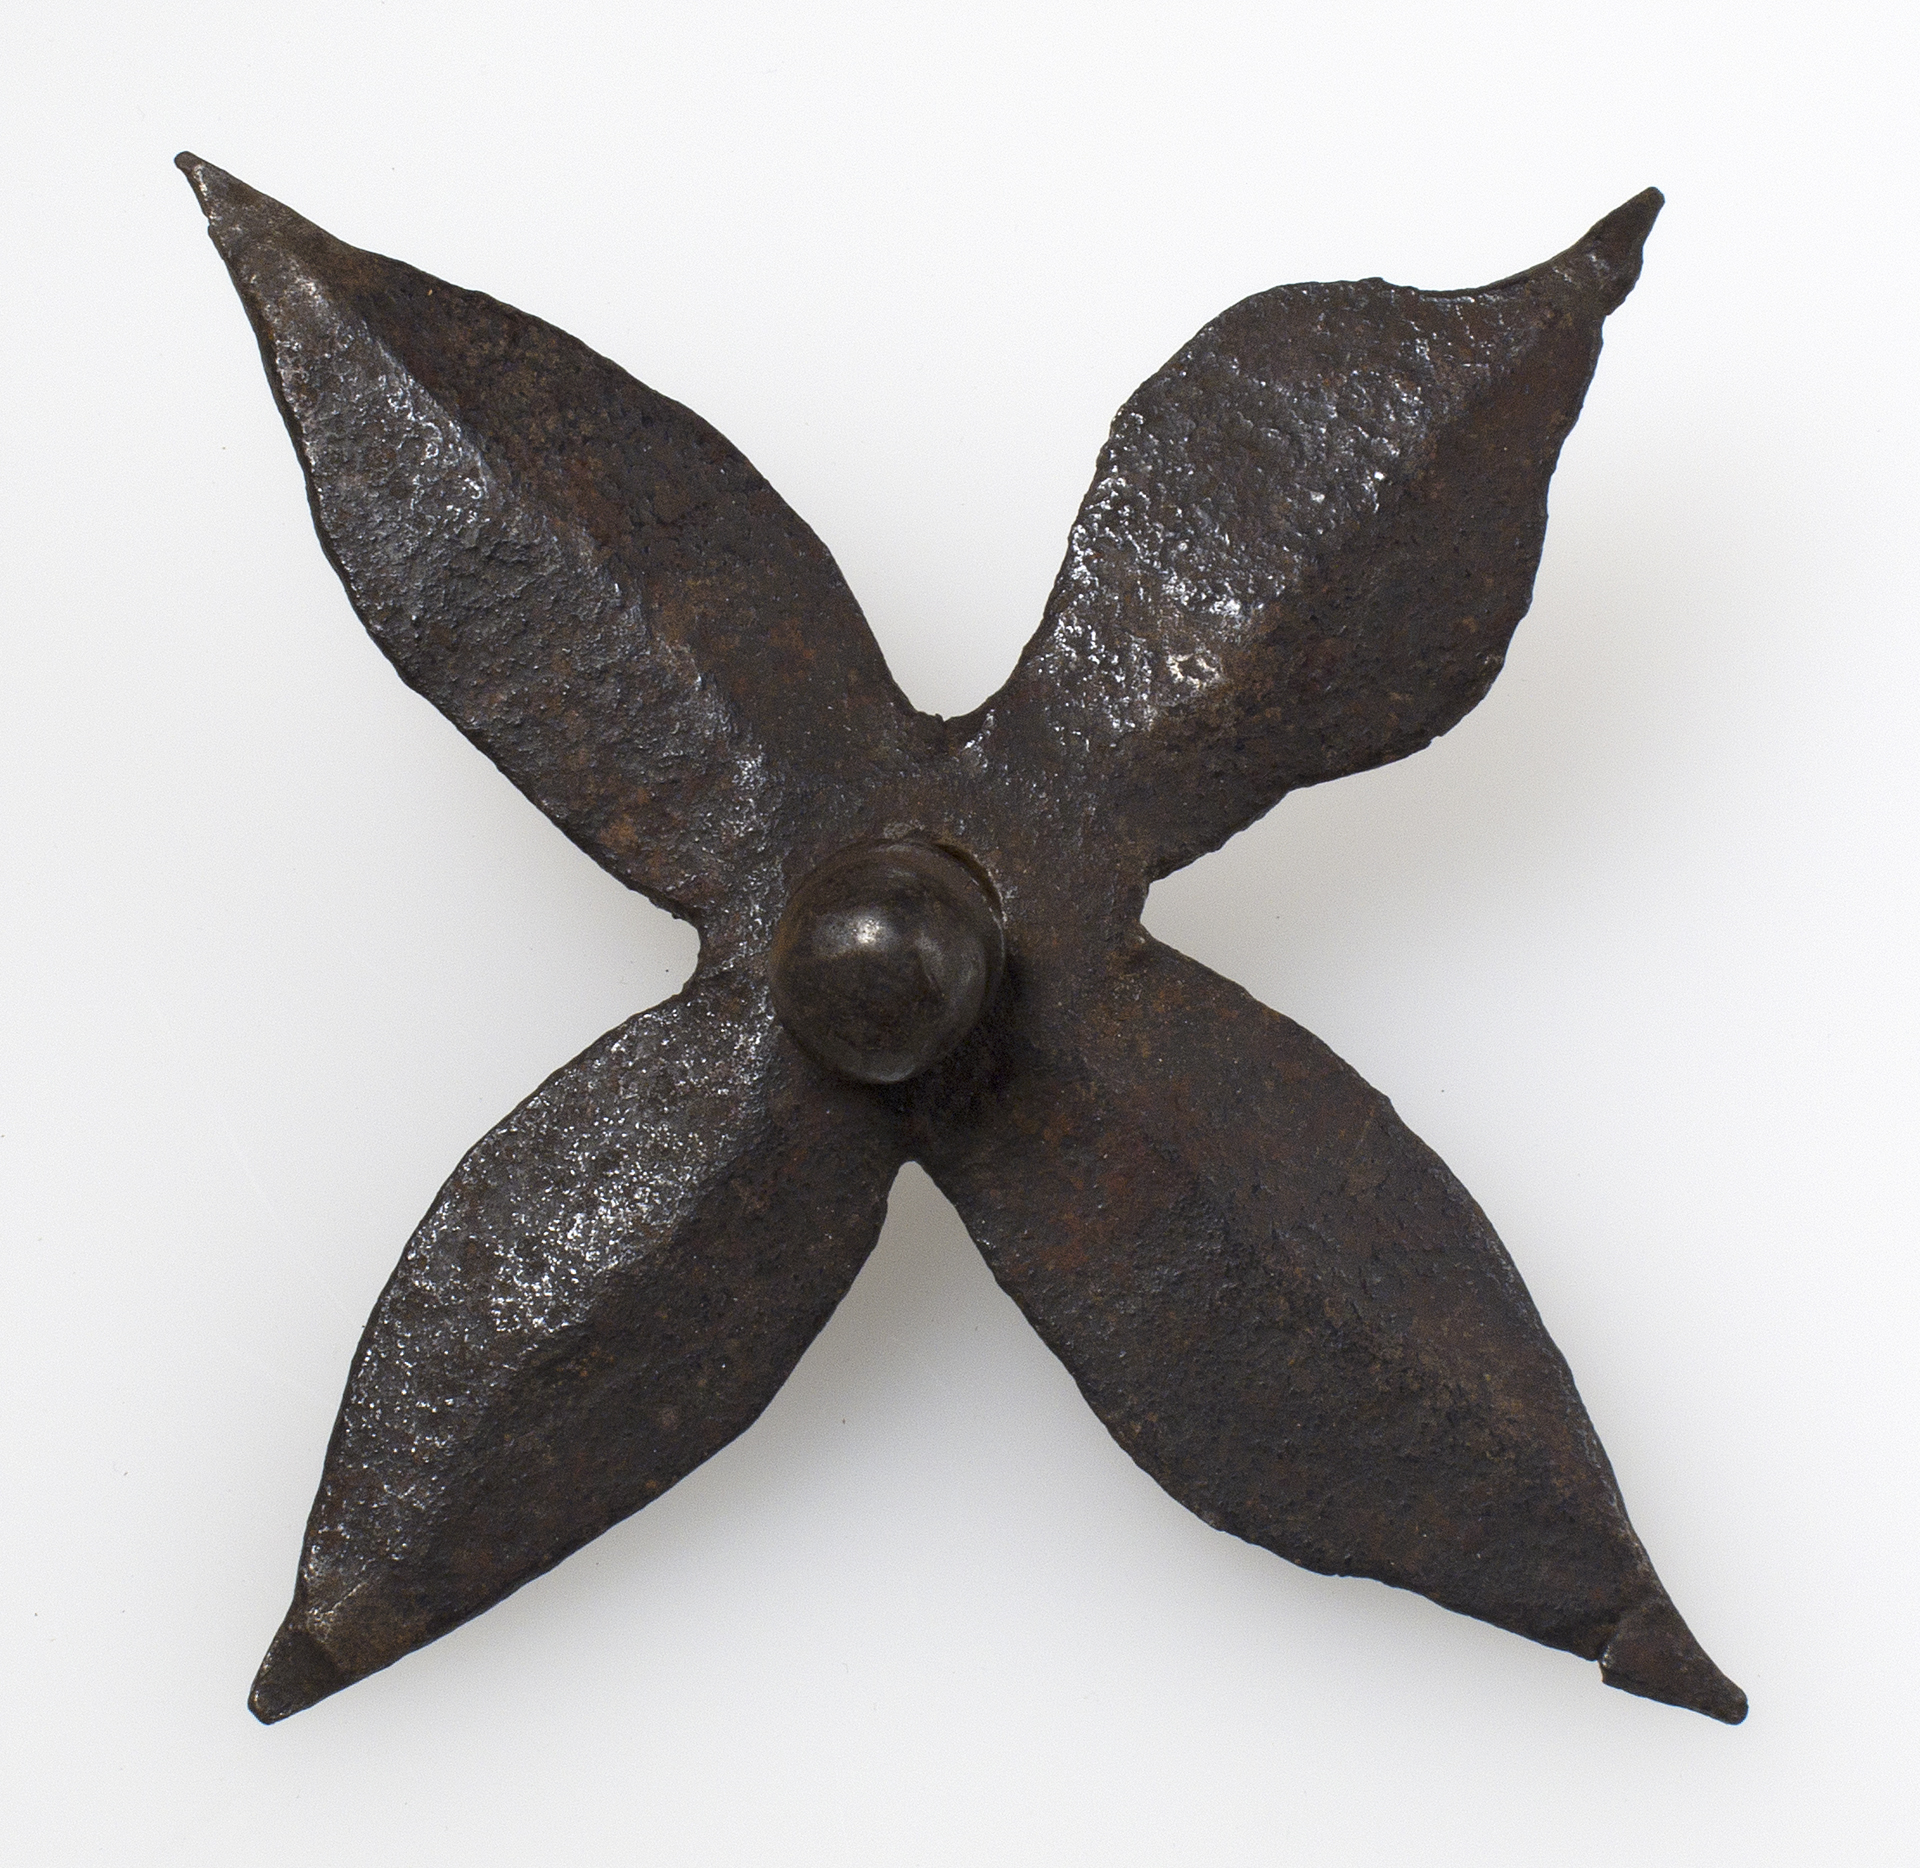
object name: plate and nail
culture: european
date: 1401-1600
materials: iron